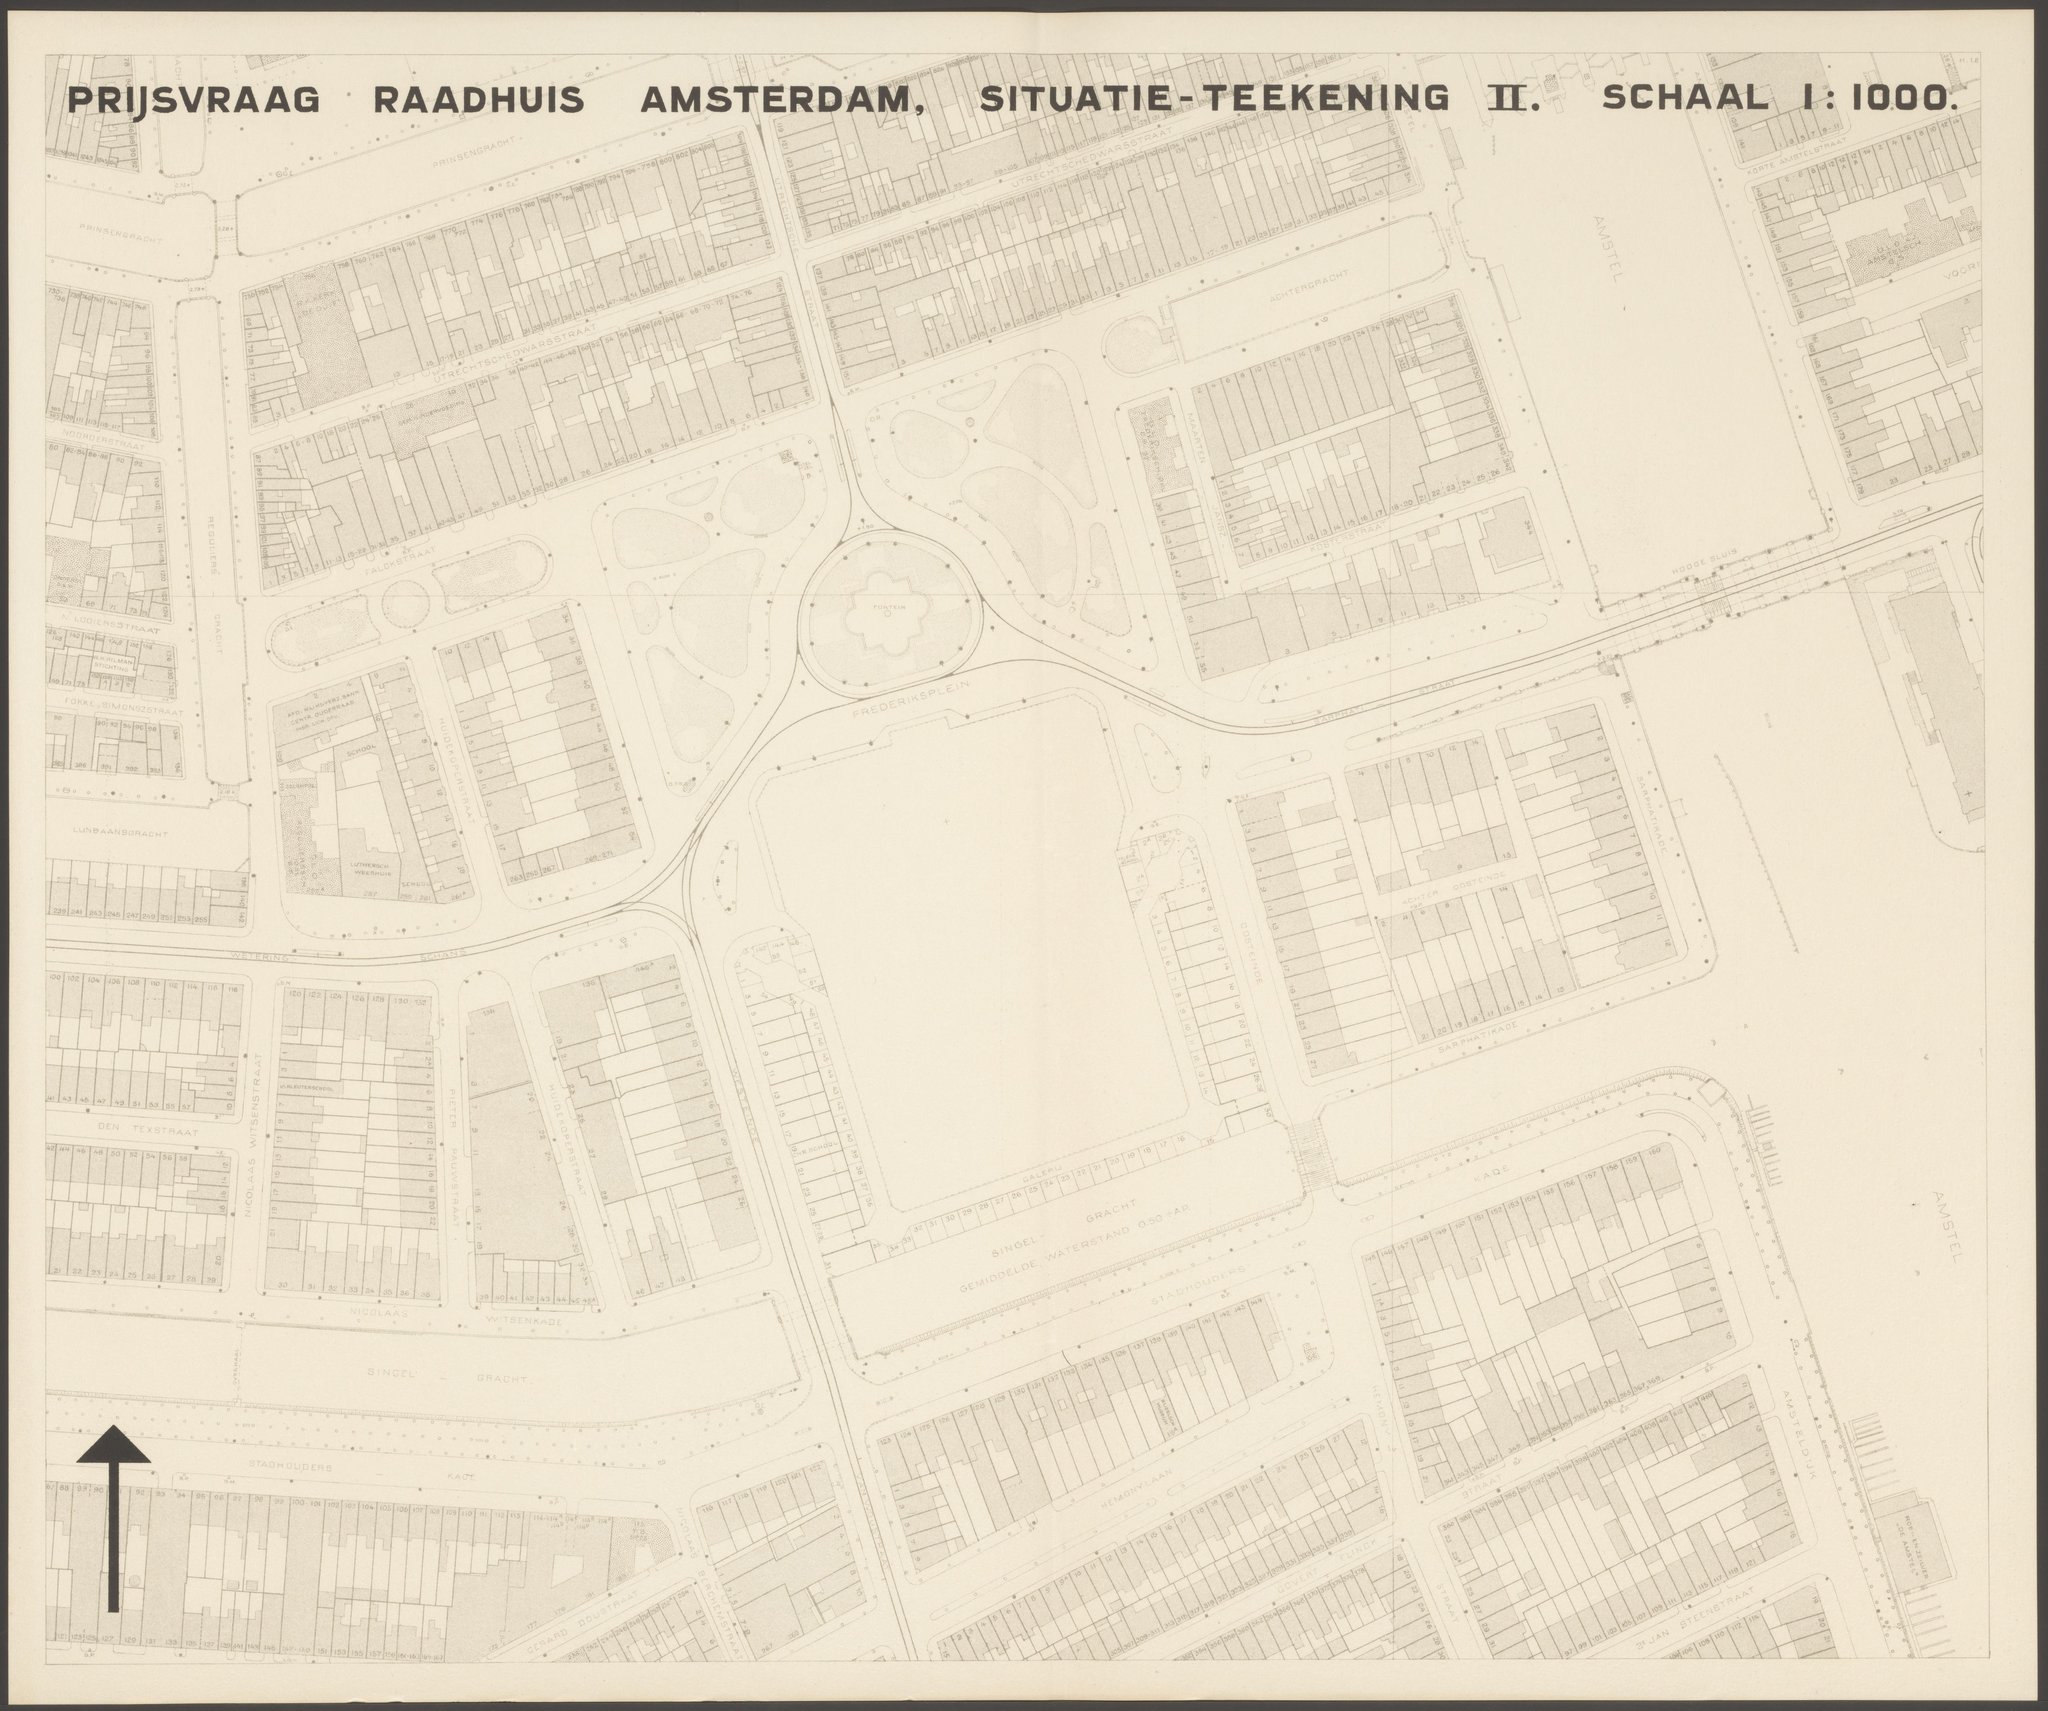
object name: print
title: Prijsvraag Raadhuis Amsterdam, Situatie-Teekening II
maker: Anonymous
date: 1935-1937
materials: paper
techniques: lithograph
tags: design, plan (~ production), city-view in general; 'veduta', maps of cities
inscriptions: collector's mark: ‘17 69C’ Lugt 1641b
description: Onderwerpsrubriek binnen de Atlas Amsterdam: Nieuwe Stadhuis, van binnen: Stadhuis Frederiksplein. Prijsvraag voor een nieuw te bouwen stadhuis op de plek van het afgebrande Paleis voor Volksvlijt bij het Frederiksplein, maar nooit gerealiseerd.